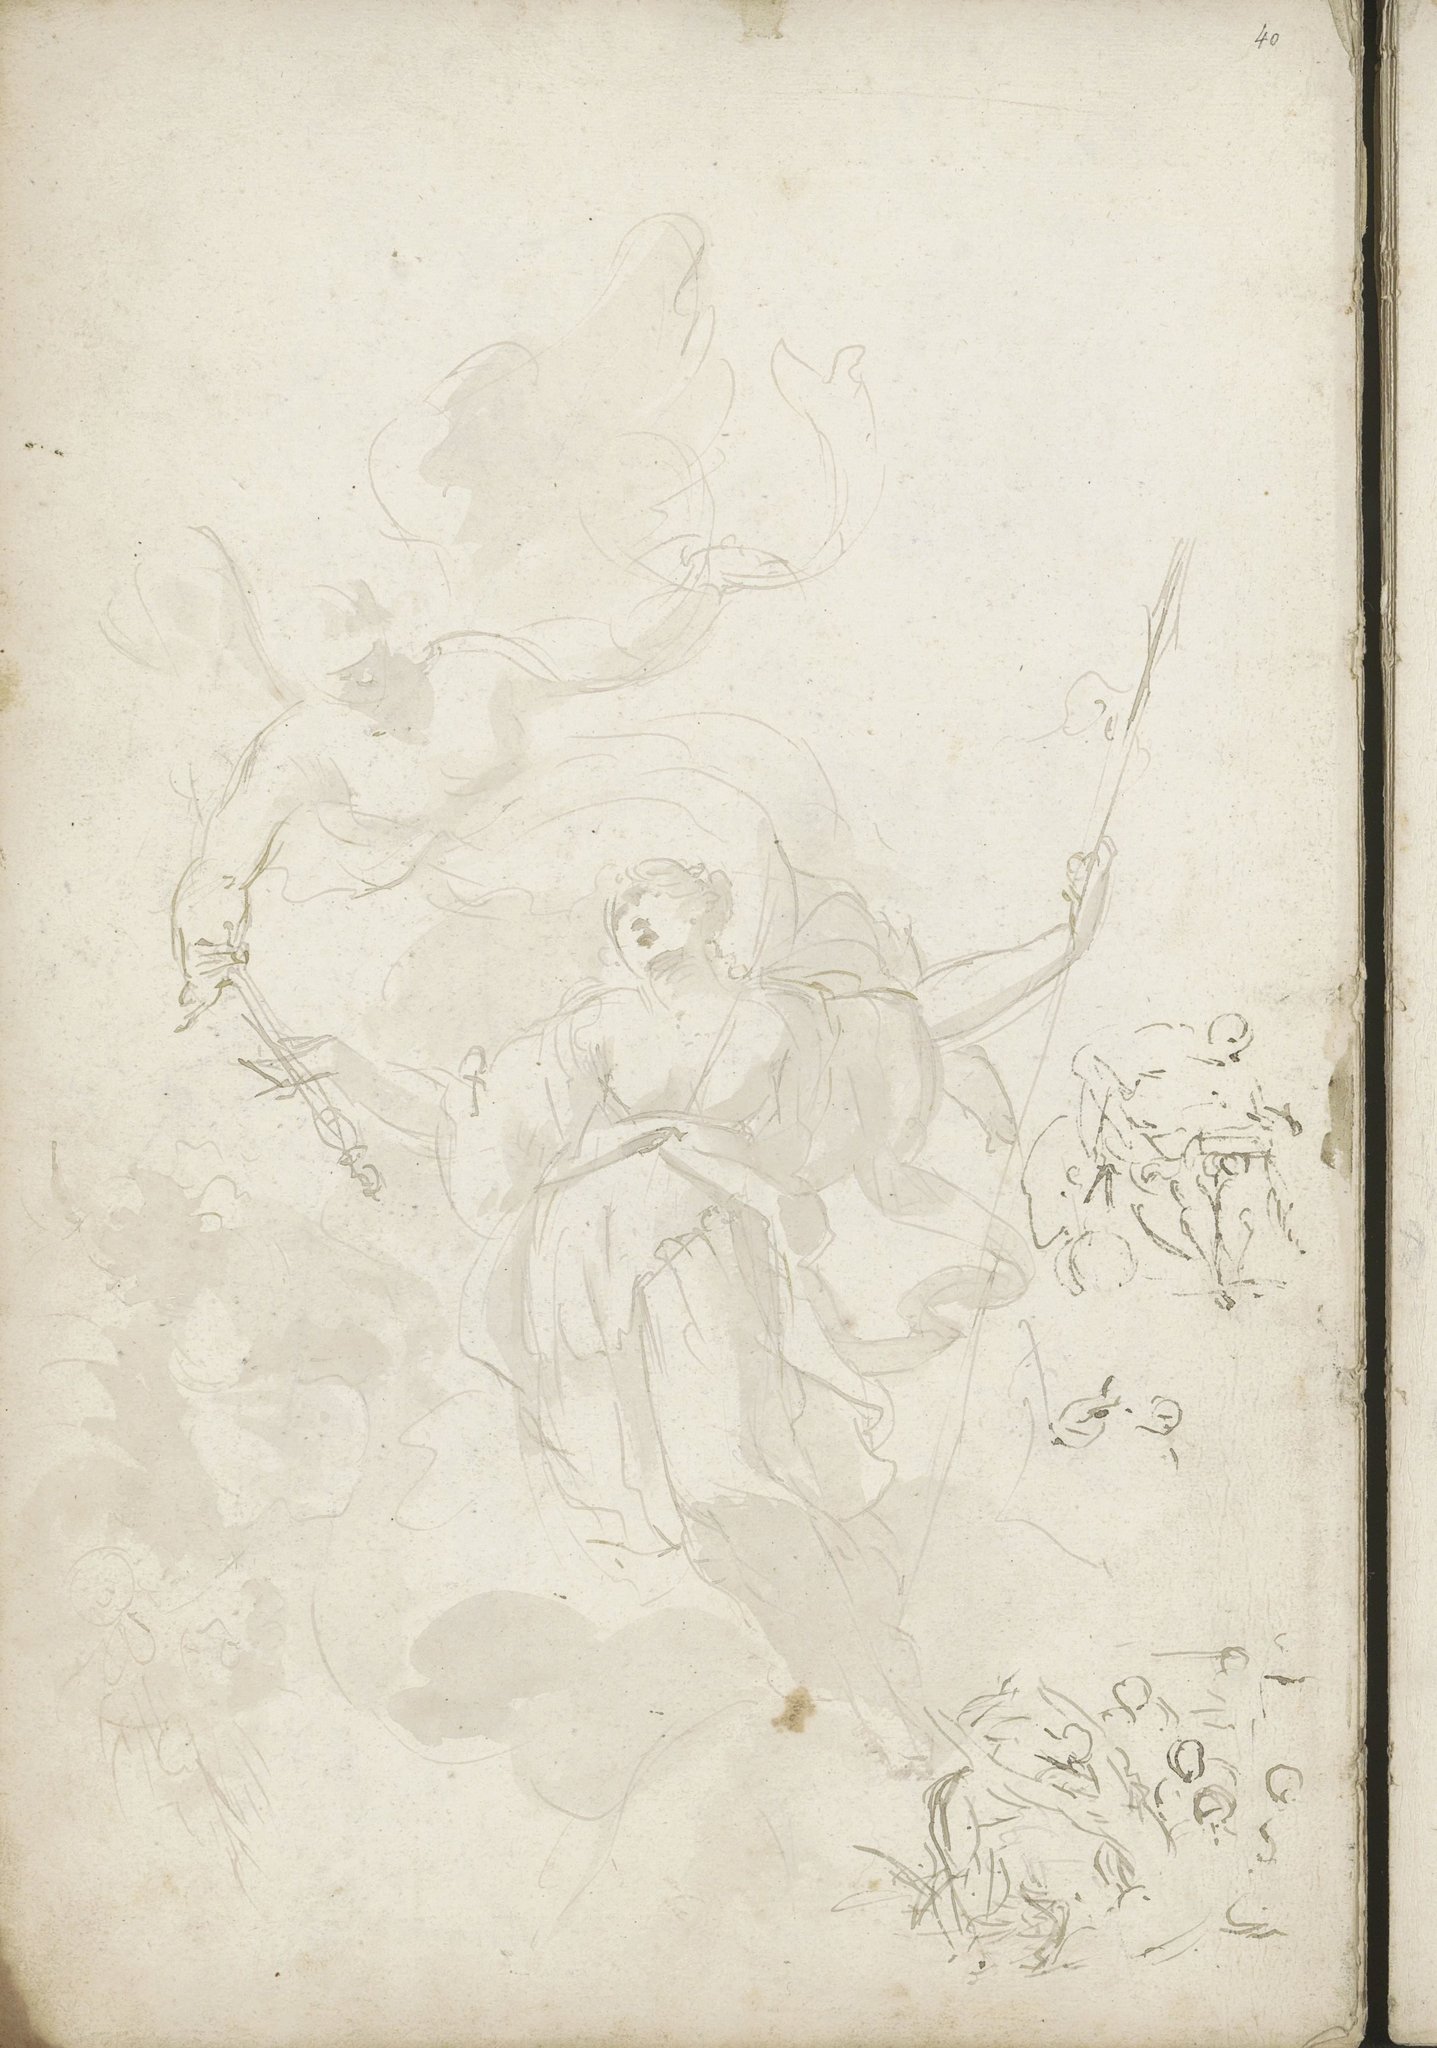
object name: sketchbook leaf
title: Staande vrouw met zwaard en lans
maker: Anonymous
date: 1650-1799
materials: ink, paper, pencil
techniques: brush, pen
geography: italy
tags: hacking and thrusting weapons, standing figure - aa - female human figure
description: Boven de vrouw zweeft een engel die haar een voorwerp aanreikt. Tevens studies van figuren. Bladzijde 40 uit een schetsboek met 72 bladzijden.